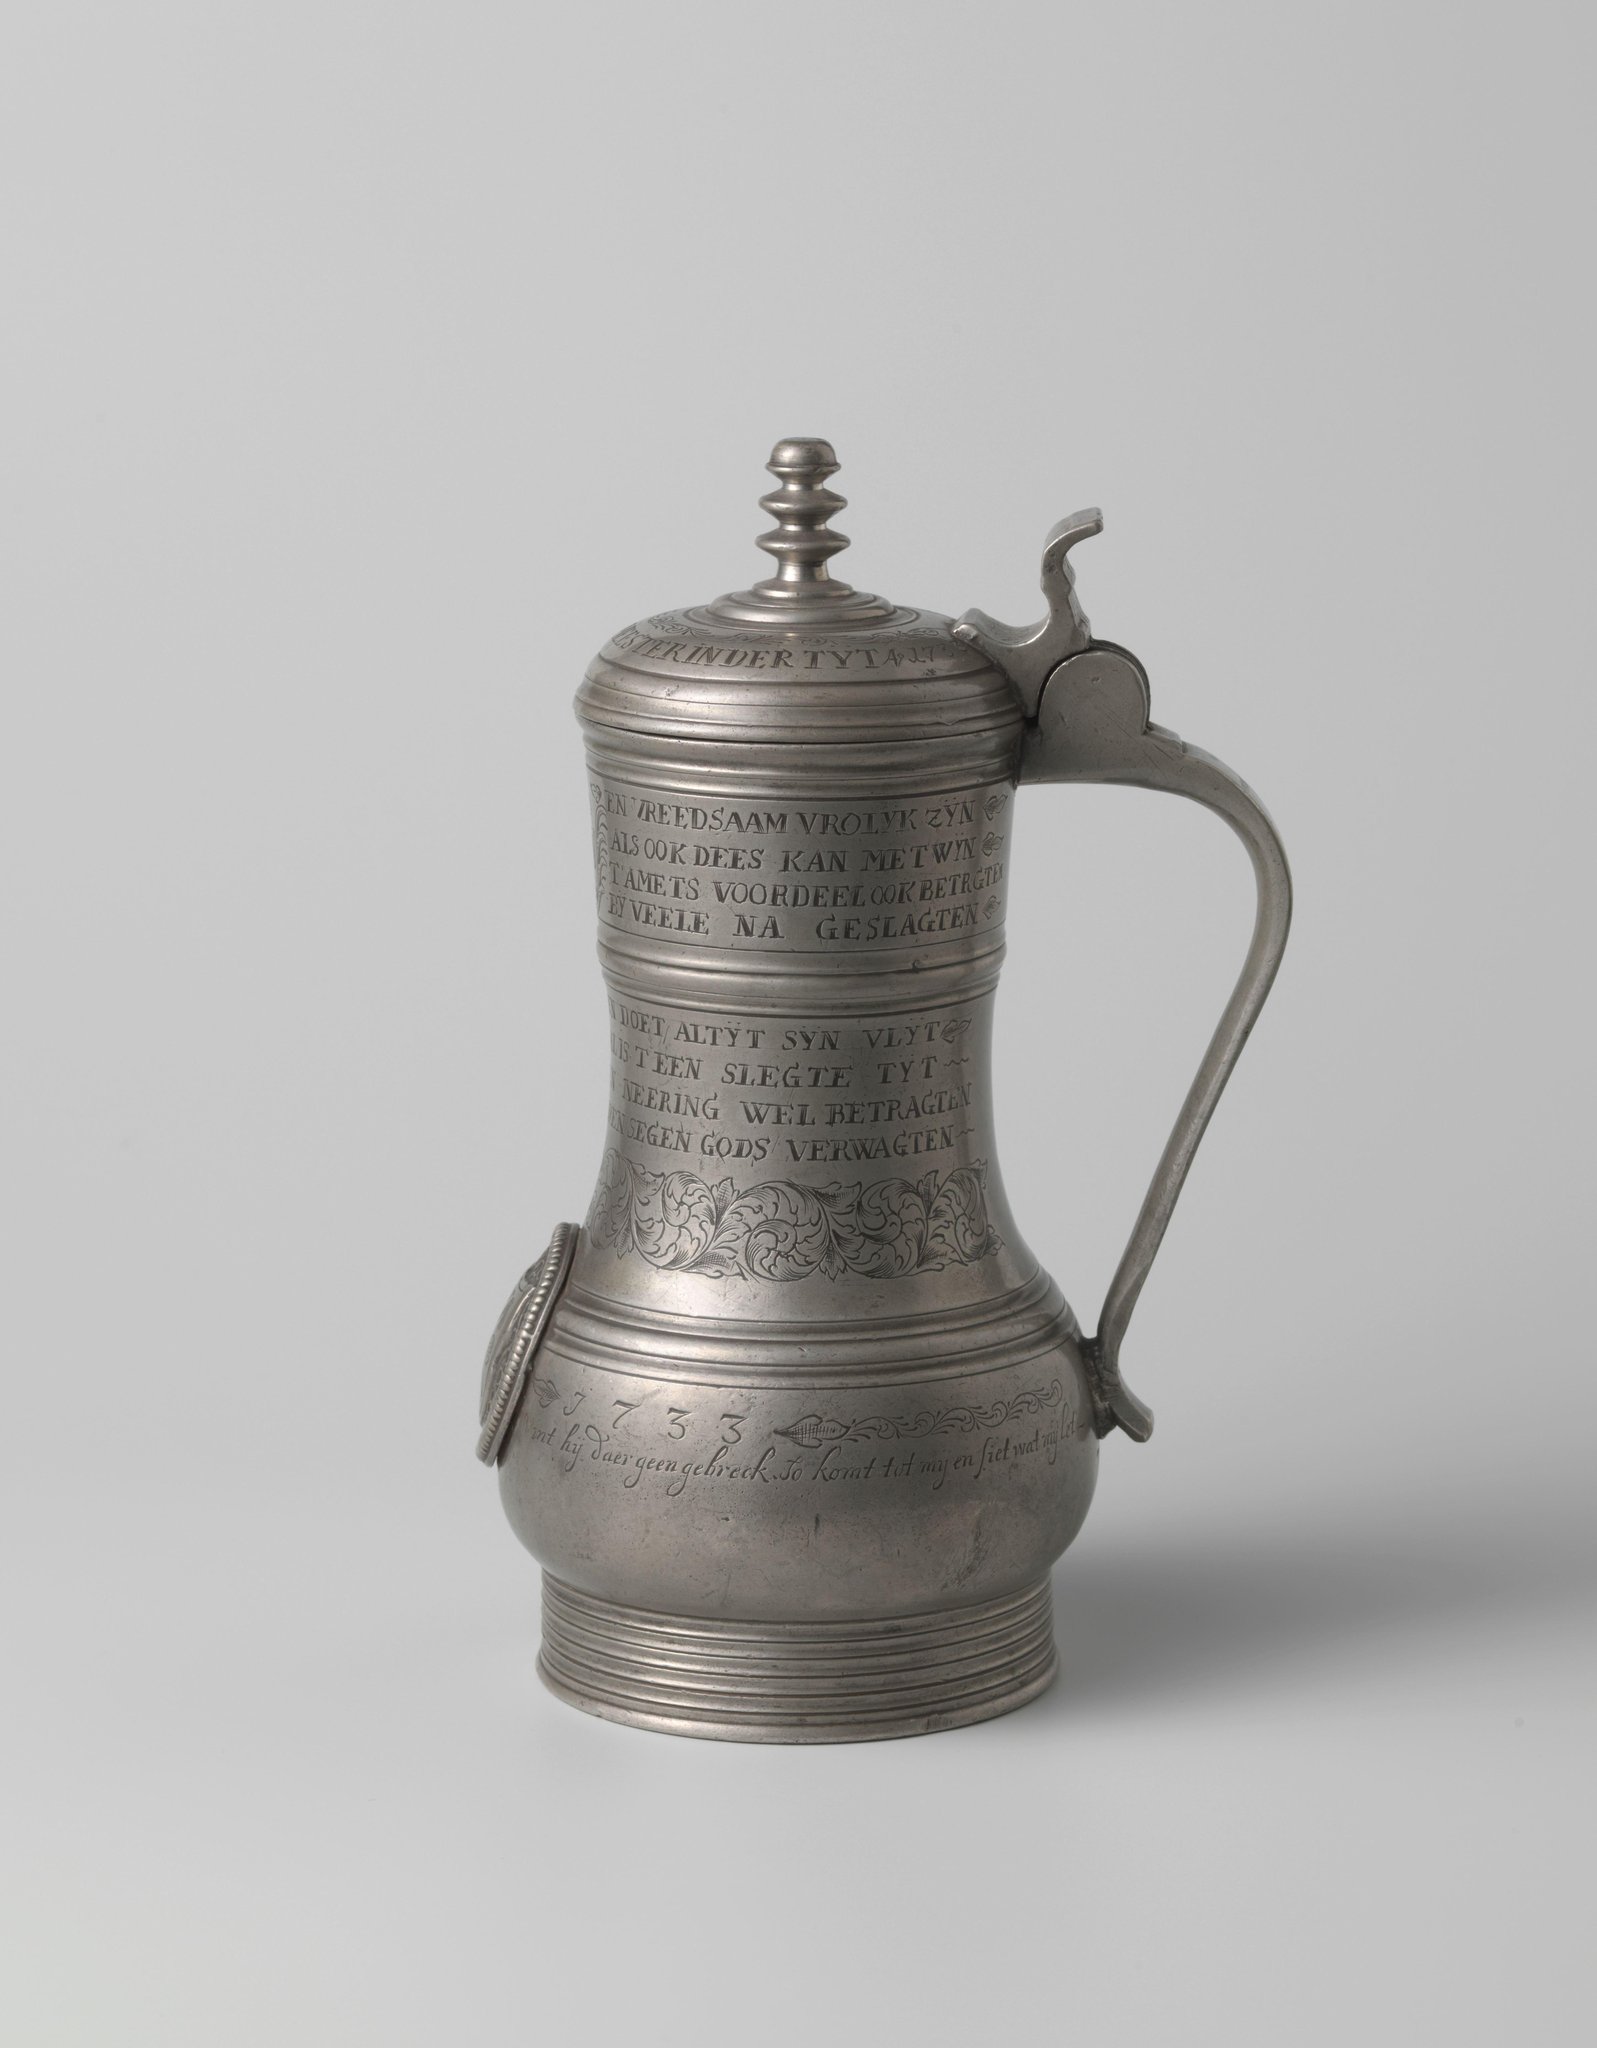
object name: jug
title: Gildekan van tin met deksel en opschrift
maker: johannes rethy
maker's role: pewterers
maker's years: -1775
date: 1733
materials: tin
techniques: casting, metalworking, engraving, turning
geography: nijmegen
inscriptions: quality mark, inscription: ‘OP DAT WY MATELEYCK EN VREEDSAAM VROLYK ZYN / DAAR TOE IS DEESE DAGH ALS OOK DEES KAN MET WYN / DOG LAAT ONS TE SAAM T'AMETS VOORDEEL OOK BETRGTEN / ZO BLYFT ONS NAAM IN ROEM BY VEELE NA GESLAGTEN / DIE HEM TOT BACKEN VOEGT.EN DOET ALTYT SYN VLYT / MOET WESEN VERGENOEGT.AL IS T EEN SLEGTE TYT / HY MOET OOK SYN BEROEP.EN NEERING WEL BETRAGTEN / EN DAN MET LEYSAM HYT.DEN SEGEN GODS VERWAGTEN/ ANNO 1733 / Die mij berecht of te mijne.die gaet thuijs berecht de sijne Vint hij daer geen gebreck.so komt tot mij en siet wat mij let’, inscription: ‘GERADU PETERS VAN DRIEL MEESTER IN DER TYT Ao 1733’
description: Kruik van tin, van het bakkersgilde. De voet is versierd met geprofileerde banden. Daarboven de balustervormige kruik met opschrift en een opliggend medaillon met een wapen. De bovenzijde wordt afgesloten met een gewelfd deksel met een knop. De eenvoudige duimrust loopt via een dubbelkakig scharnier over in het handvat, dat onderaan iets naar buiten krult.